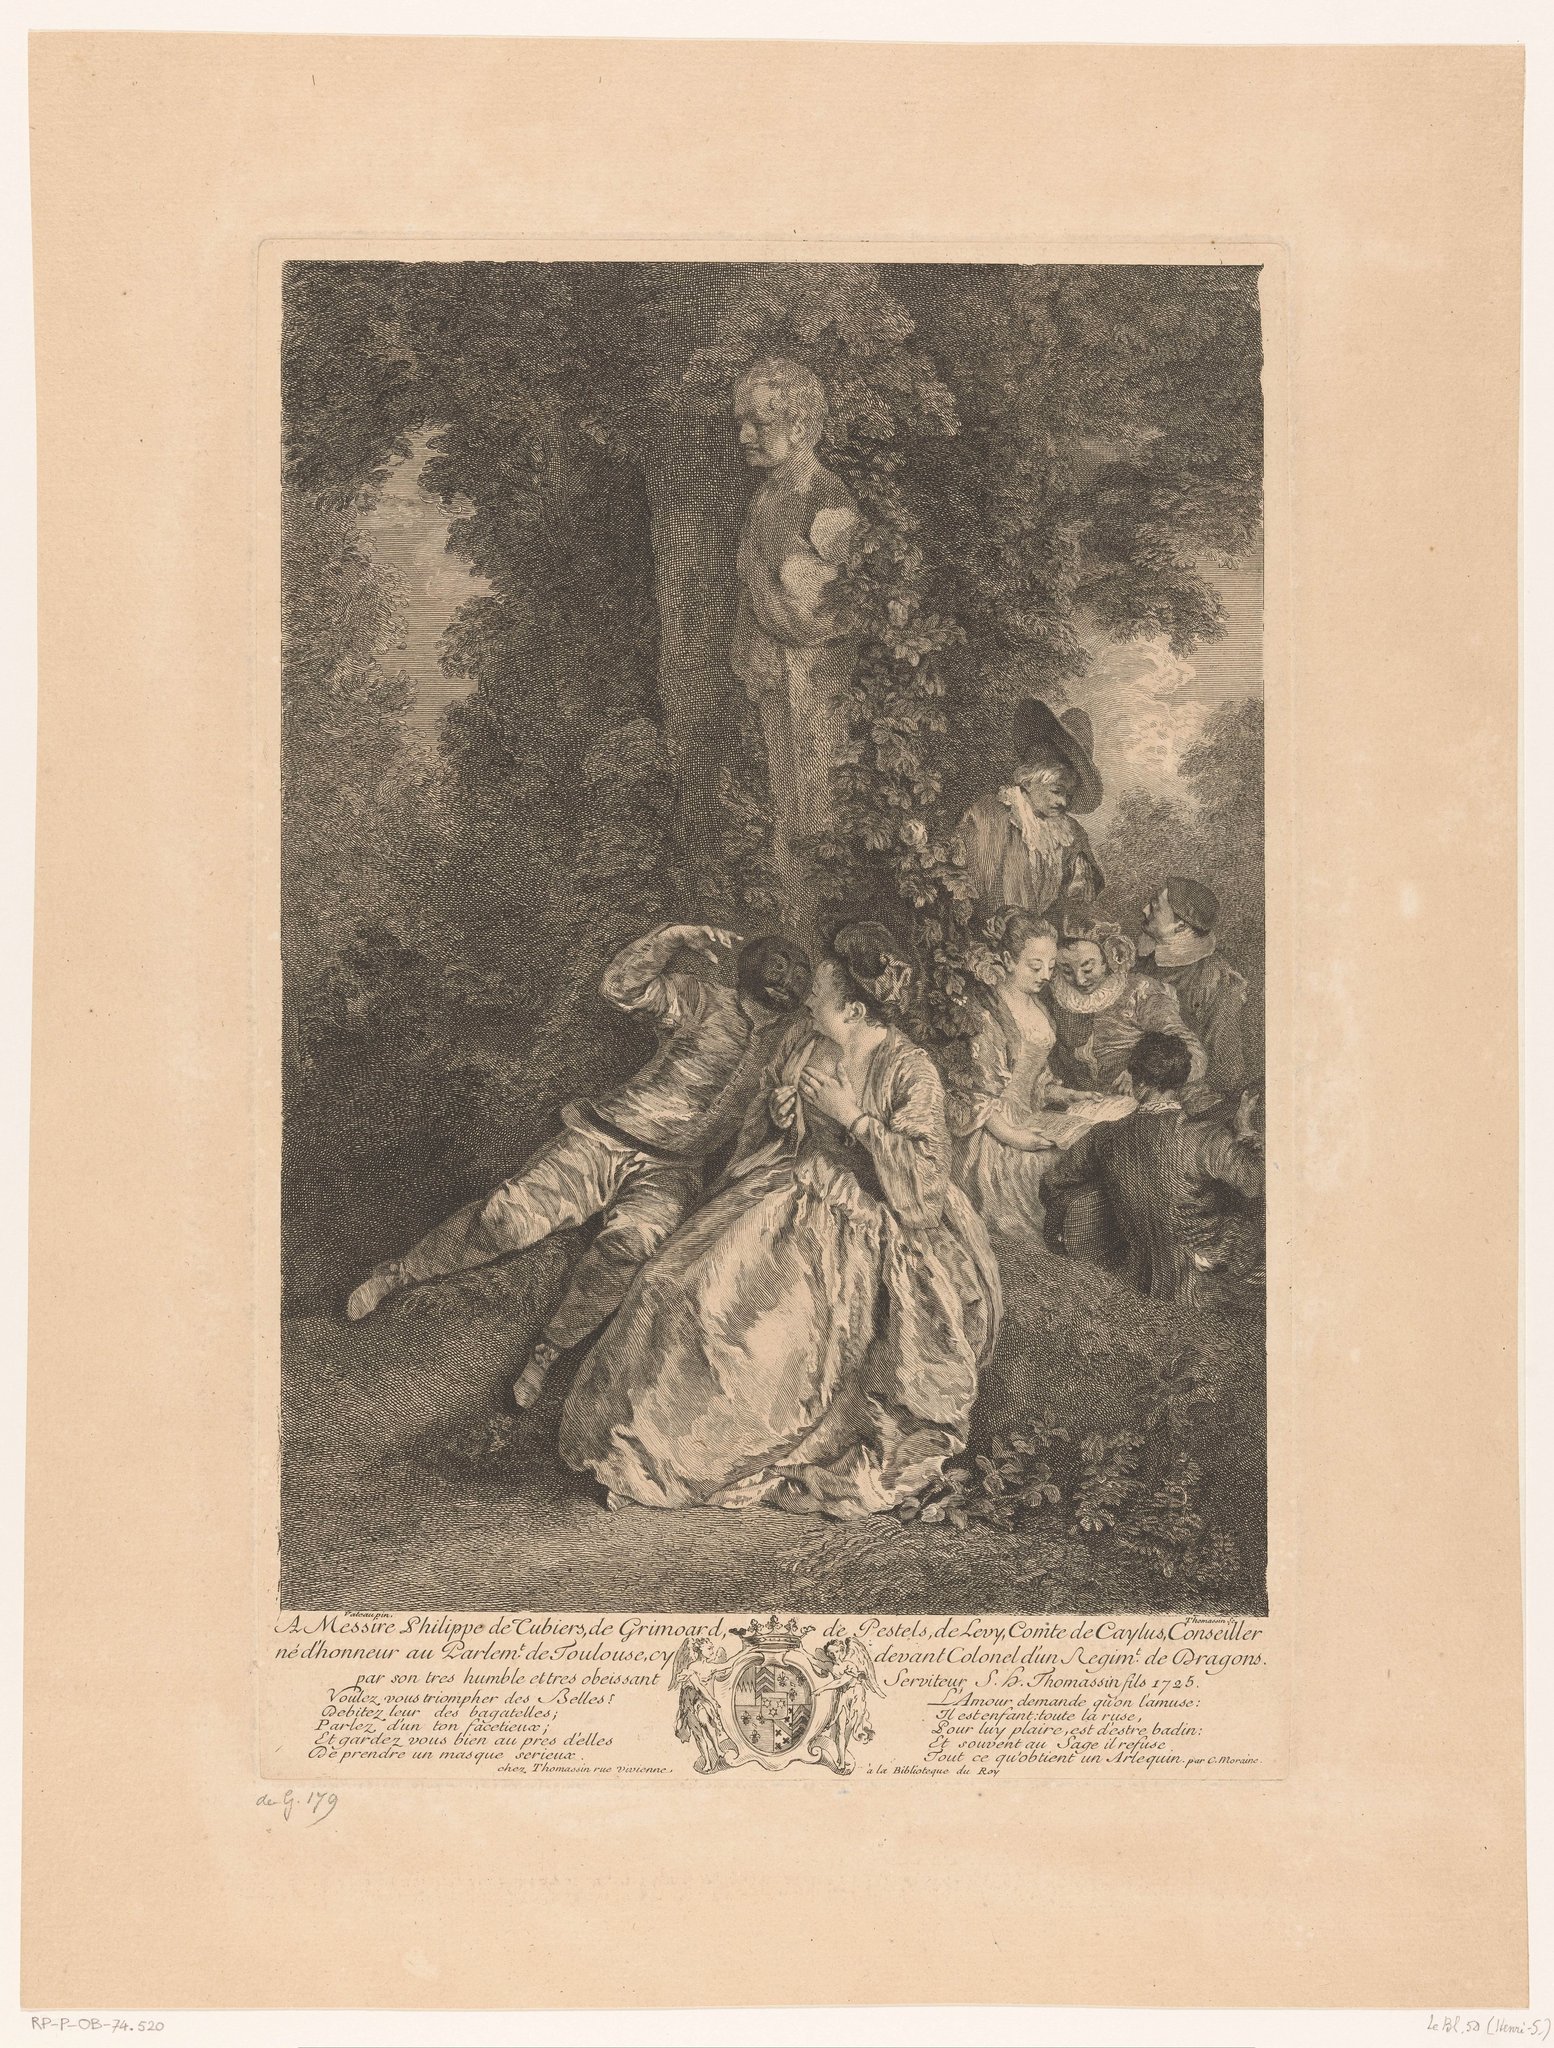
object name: print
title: Oeuvre van Antoine Watteau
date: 1725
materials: paper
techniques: engraving, etching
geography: paris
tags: types in 'commedia dell'arte': colombine, types in 'commedia dell'arte': harlequin, sculpture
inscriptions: collector's mark: Lugt 2228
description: Maakt deel uit van een serie van 271 platen naar schilderijen door Watteau, verdeeld over drie delen, gecoördineerd door Jean de Jullienne en uitgegeven in Parijs in 1735. Sommige platen werden reeds tijdens Watteau's leven gemaakt. De Julienne en Watteau waren goede vrienden. Het schilderij door Watteau bevindt zich in de Wallace Collection te Londen, inv.nr. P387.